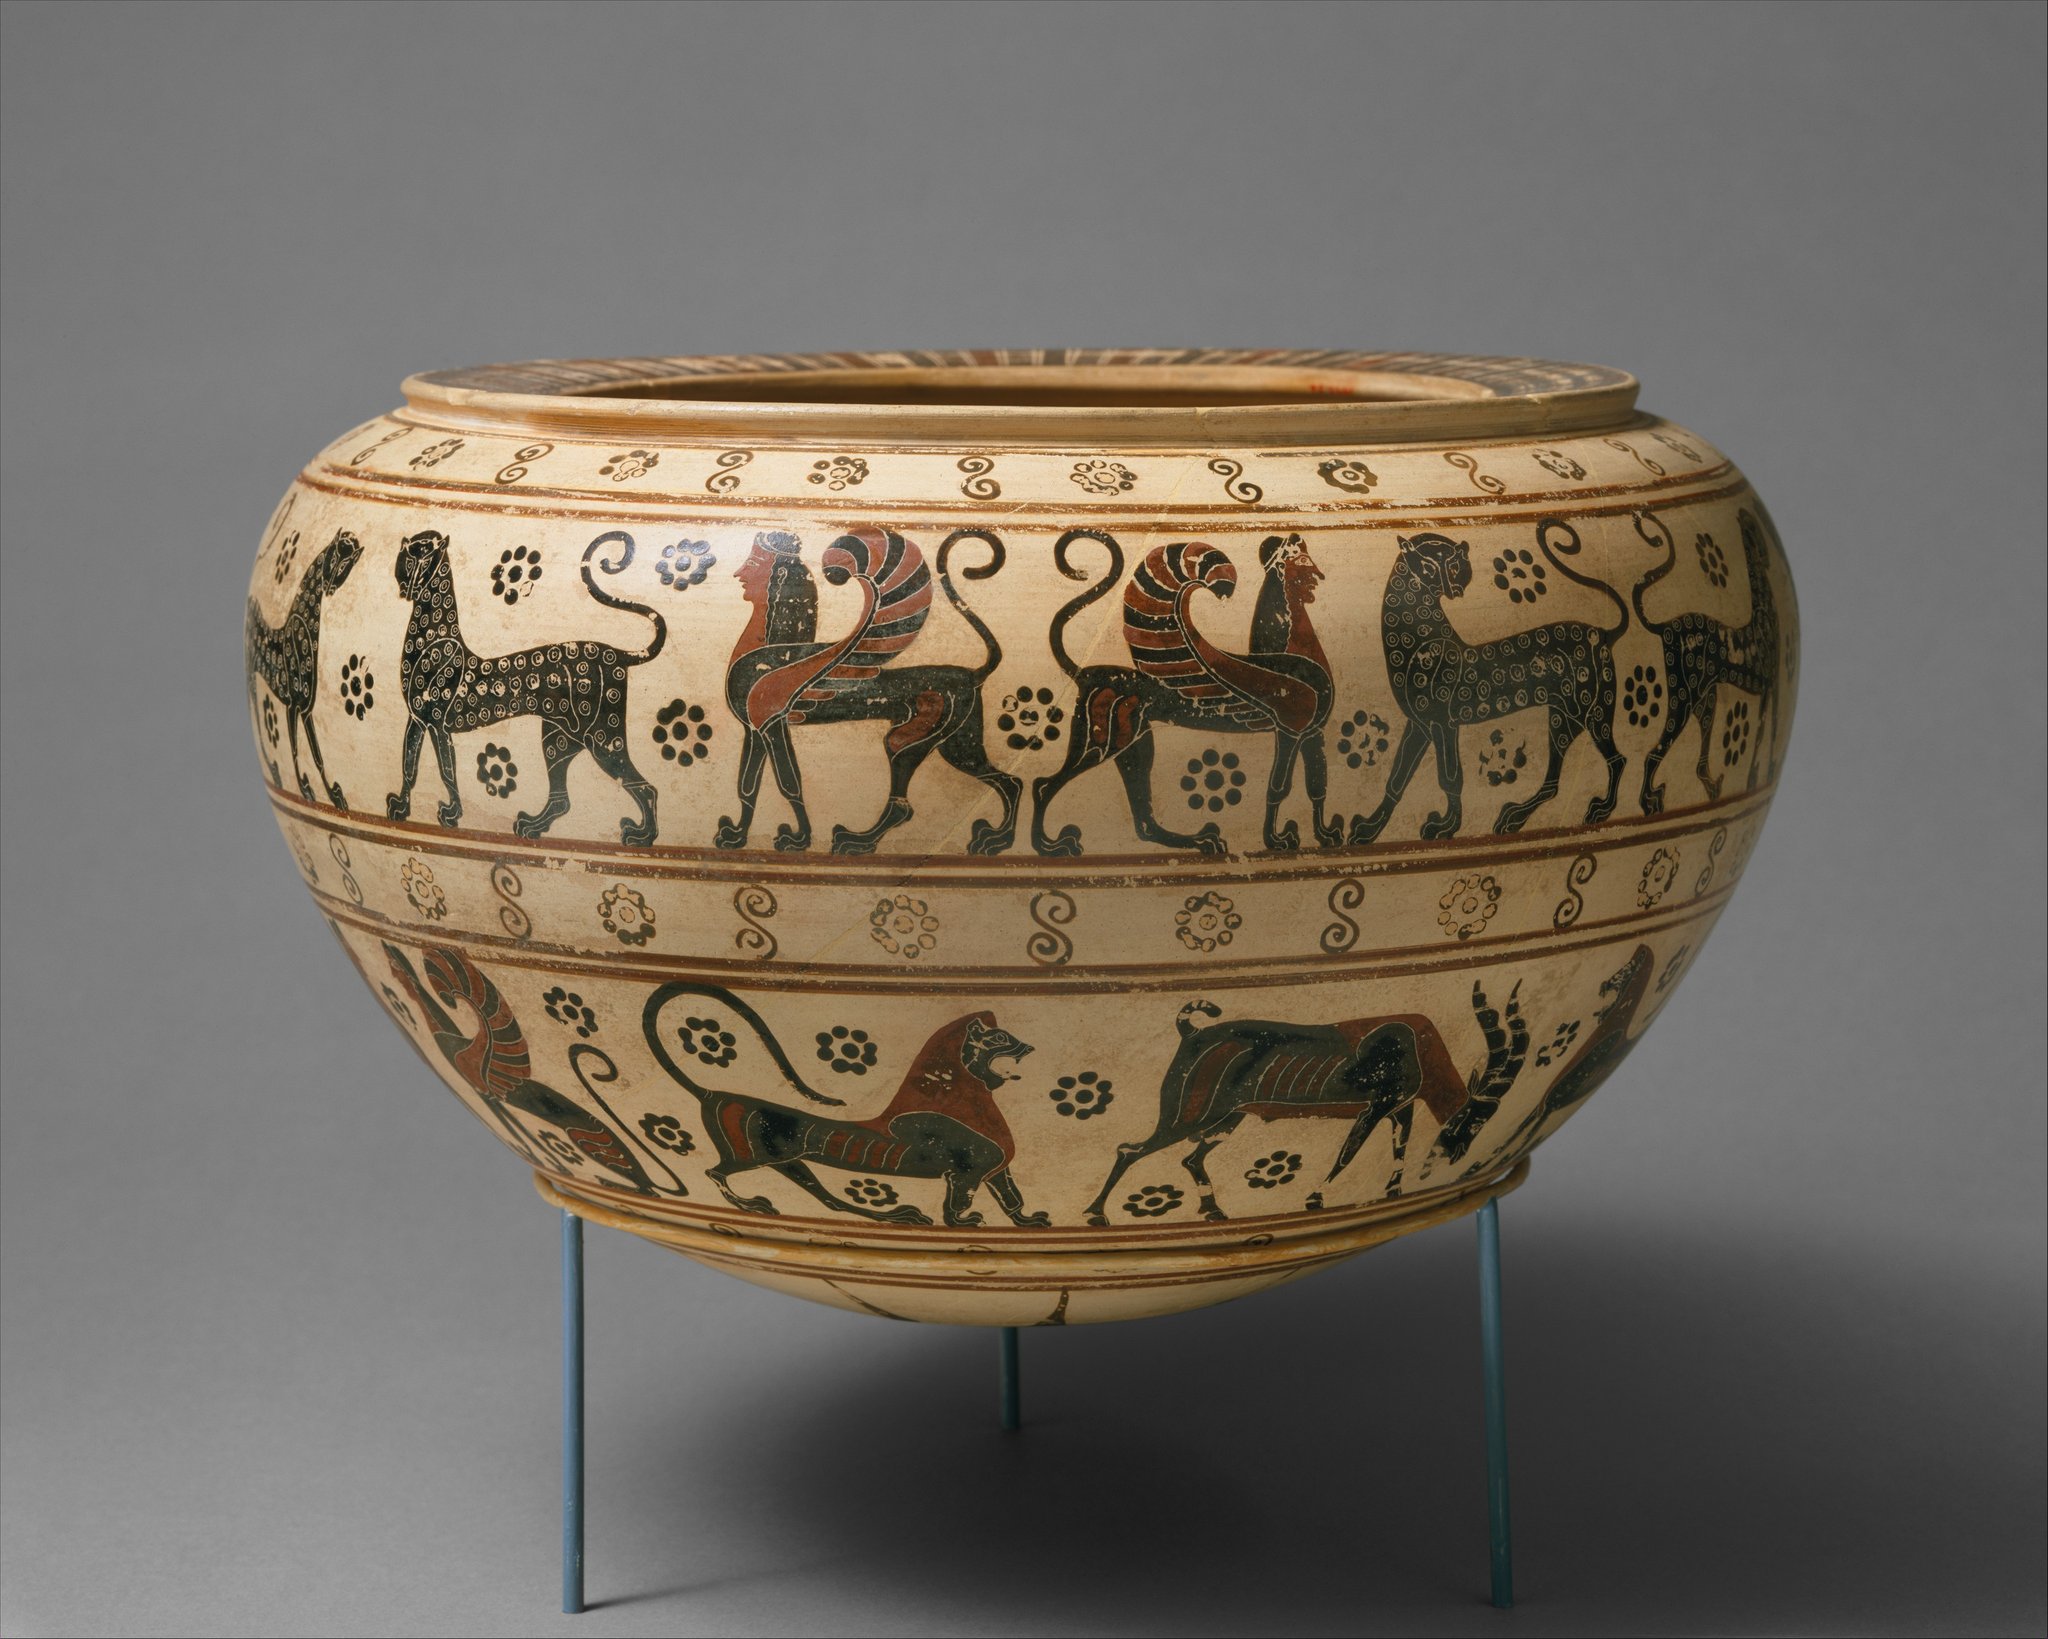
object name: dinos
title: Terracotta dinos (mixing bowl)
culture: greek, corinthian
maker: polyteleia painter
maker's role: artist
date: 630-615 BCE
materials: terracotta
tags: sphinx,goats,lions